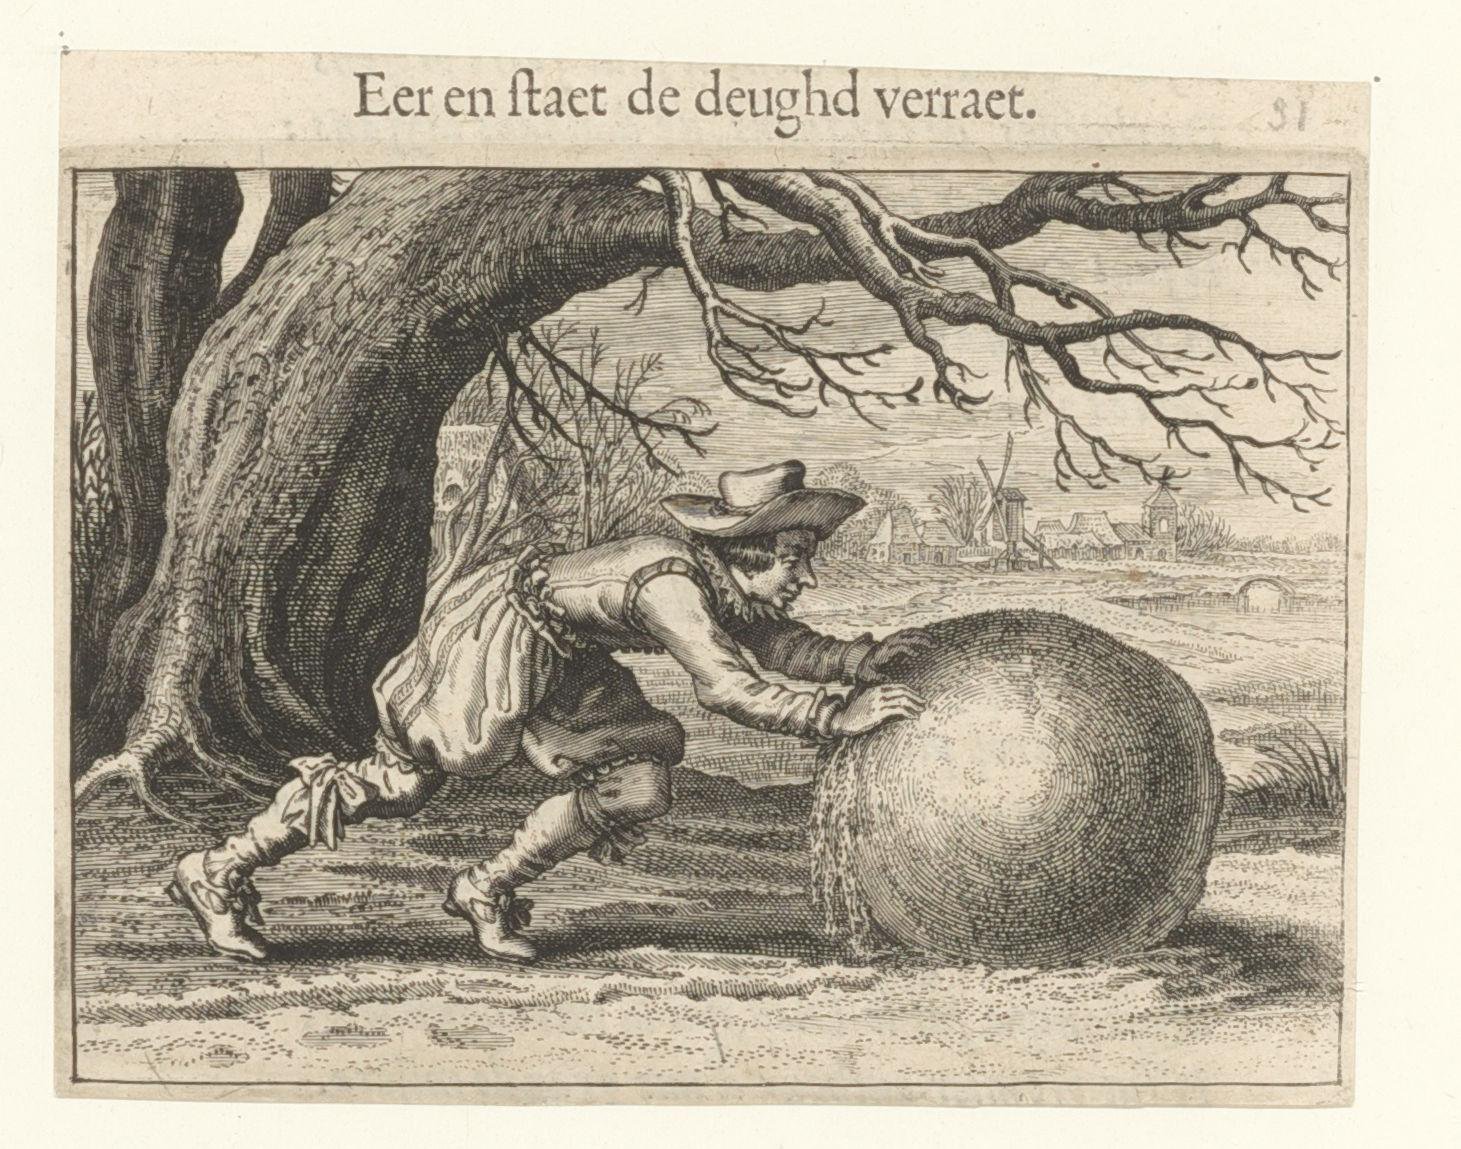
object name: print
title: Man rolt een grote bal sneeuw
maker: Anonymous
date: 1624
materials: paper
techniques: engraving, letterpress printing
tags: ambition; 'ambitione', 'amor di fama' (ripa), winter, 'hyems'; 'inverno' (ripa), adult man, (making a) snowman - cc - adult(s) ~ snow and ice, proverbs, sayings, etc., snow, virtuousness; 'amor di virtù', 'attione virtuosa', 'guida sicura de' veri honori', 'virtù', 'virtù insuperabile' (ripa), cheat, deceit; 'fraude', 'inganno' (ripa)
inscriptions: stamp, collector's mark: Lugt 1641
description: Prent uit: Brune, Johan de. Zinne-werck, Voor-ghesyelt in Beelden, Ghedichten, ende breeder uyt-legginghen (...). Amsterdam: Evertsen Kloppenburch, 1624. Prent ook gebruikt in latere edities (1636 en 1661).